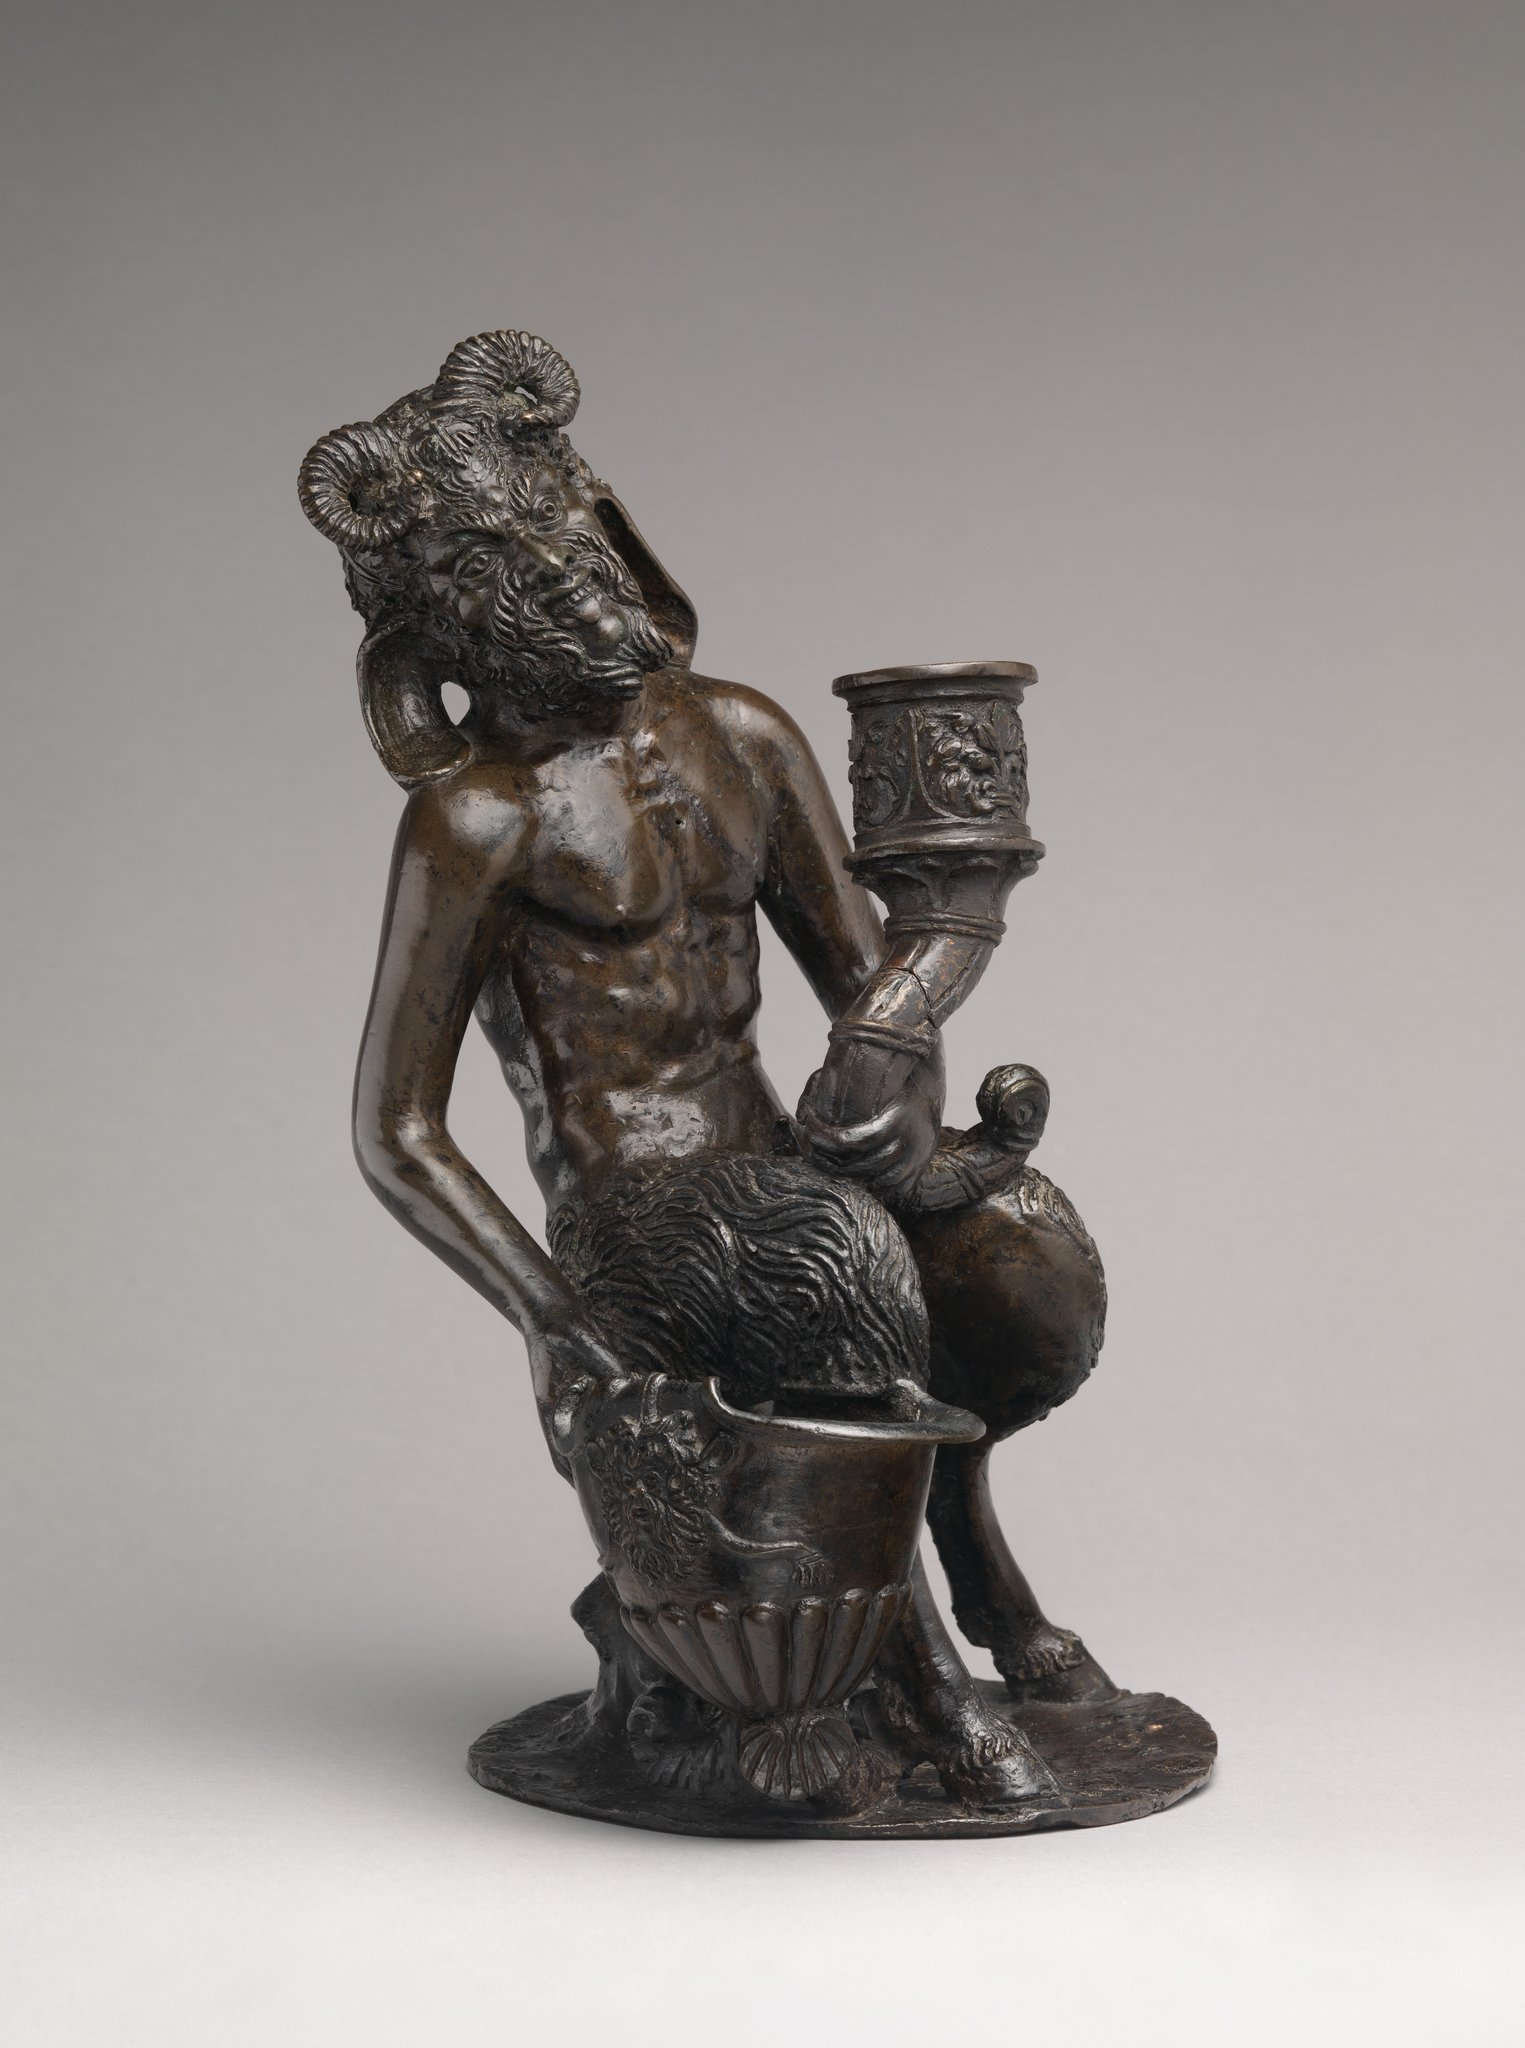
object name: statuette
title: Seated satyr with an inkwell and a candlestick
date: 1530-1540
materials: bronze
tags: satyrs